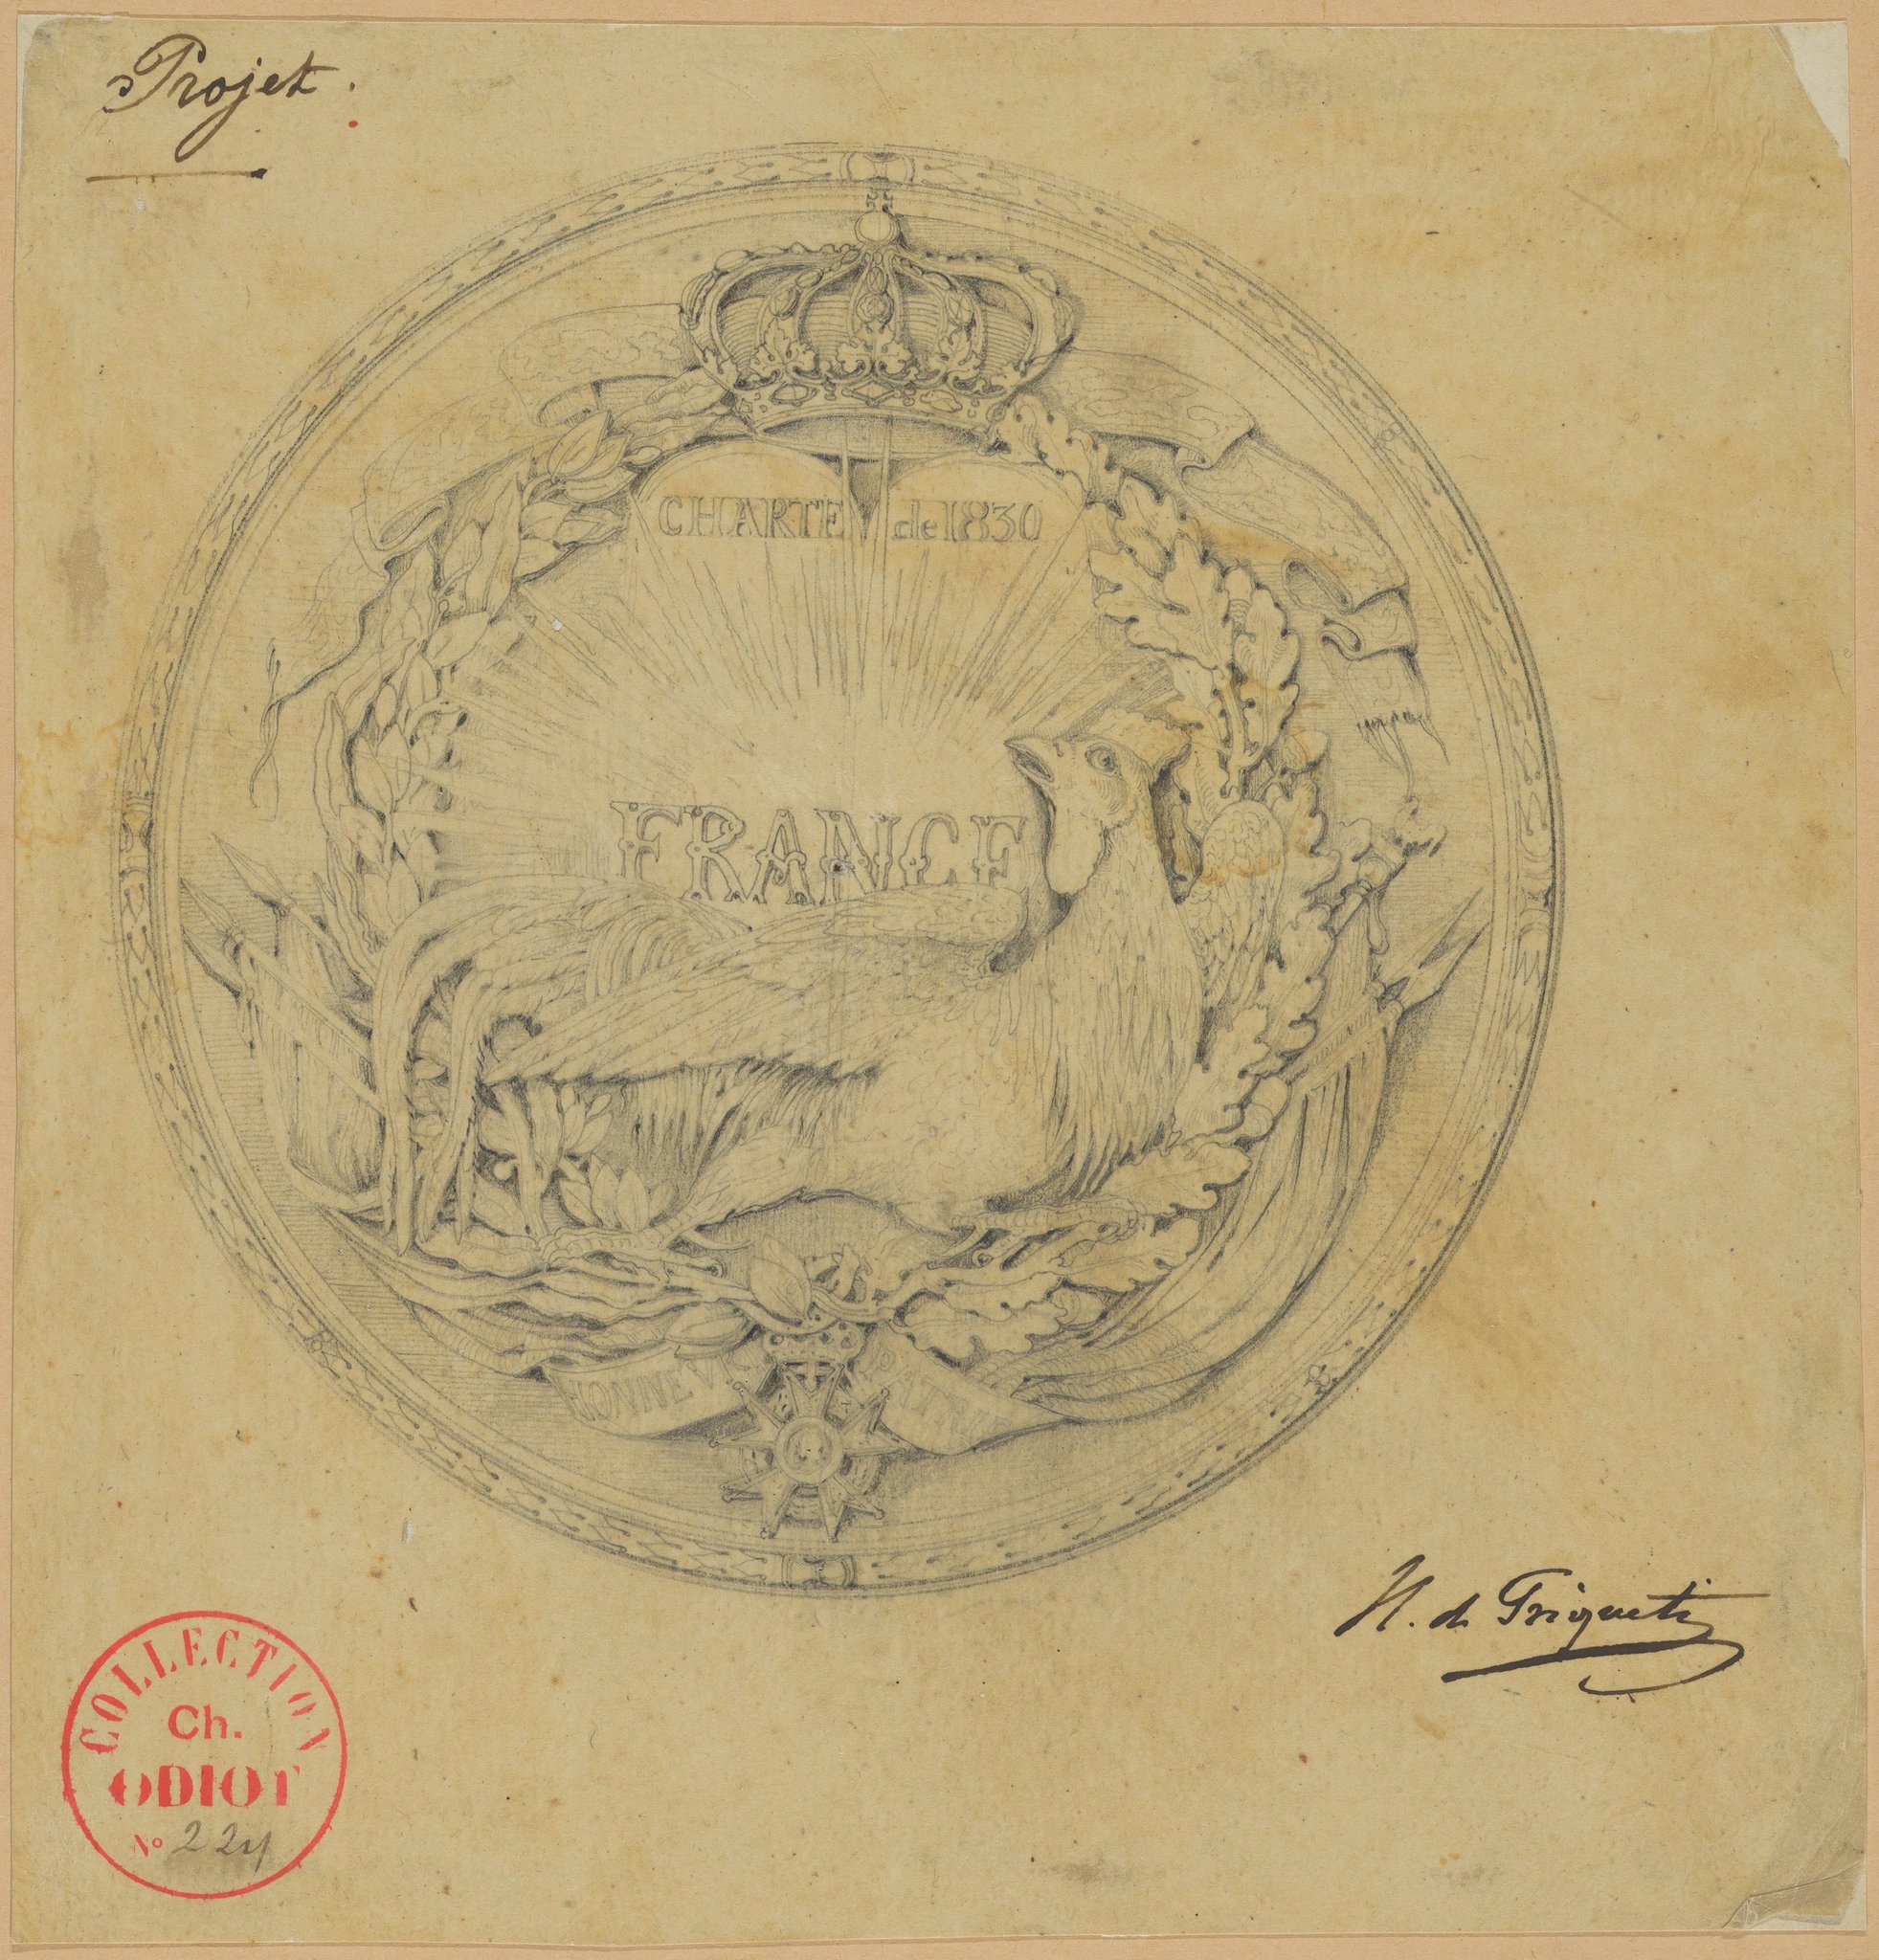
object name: drawing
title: Design for the Medal to Commemorate the Charter of 1830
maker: henri-baron de triqueti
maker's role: artist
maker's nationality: french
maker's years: 1803-1874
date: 1830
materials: chalk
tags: birds